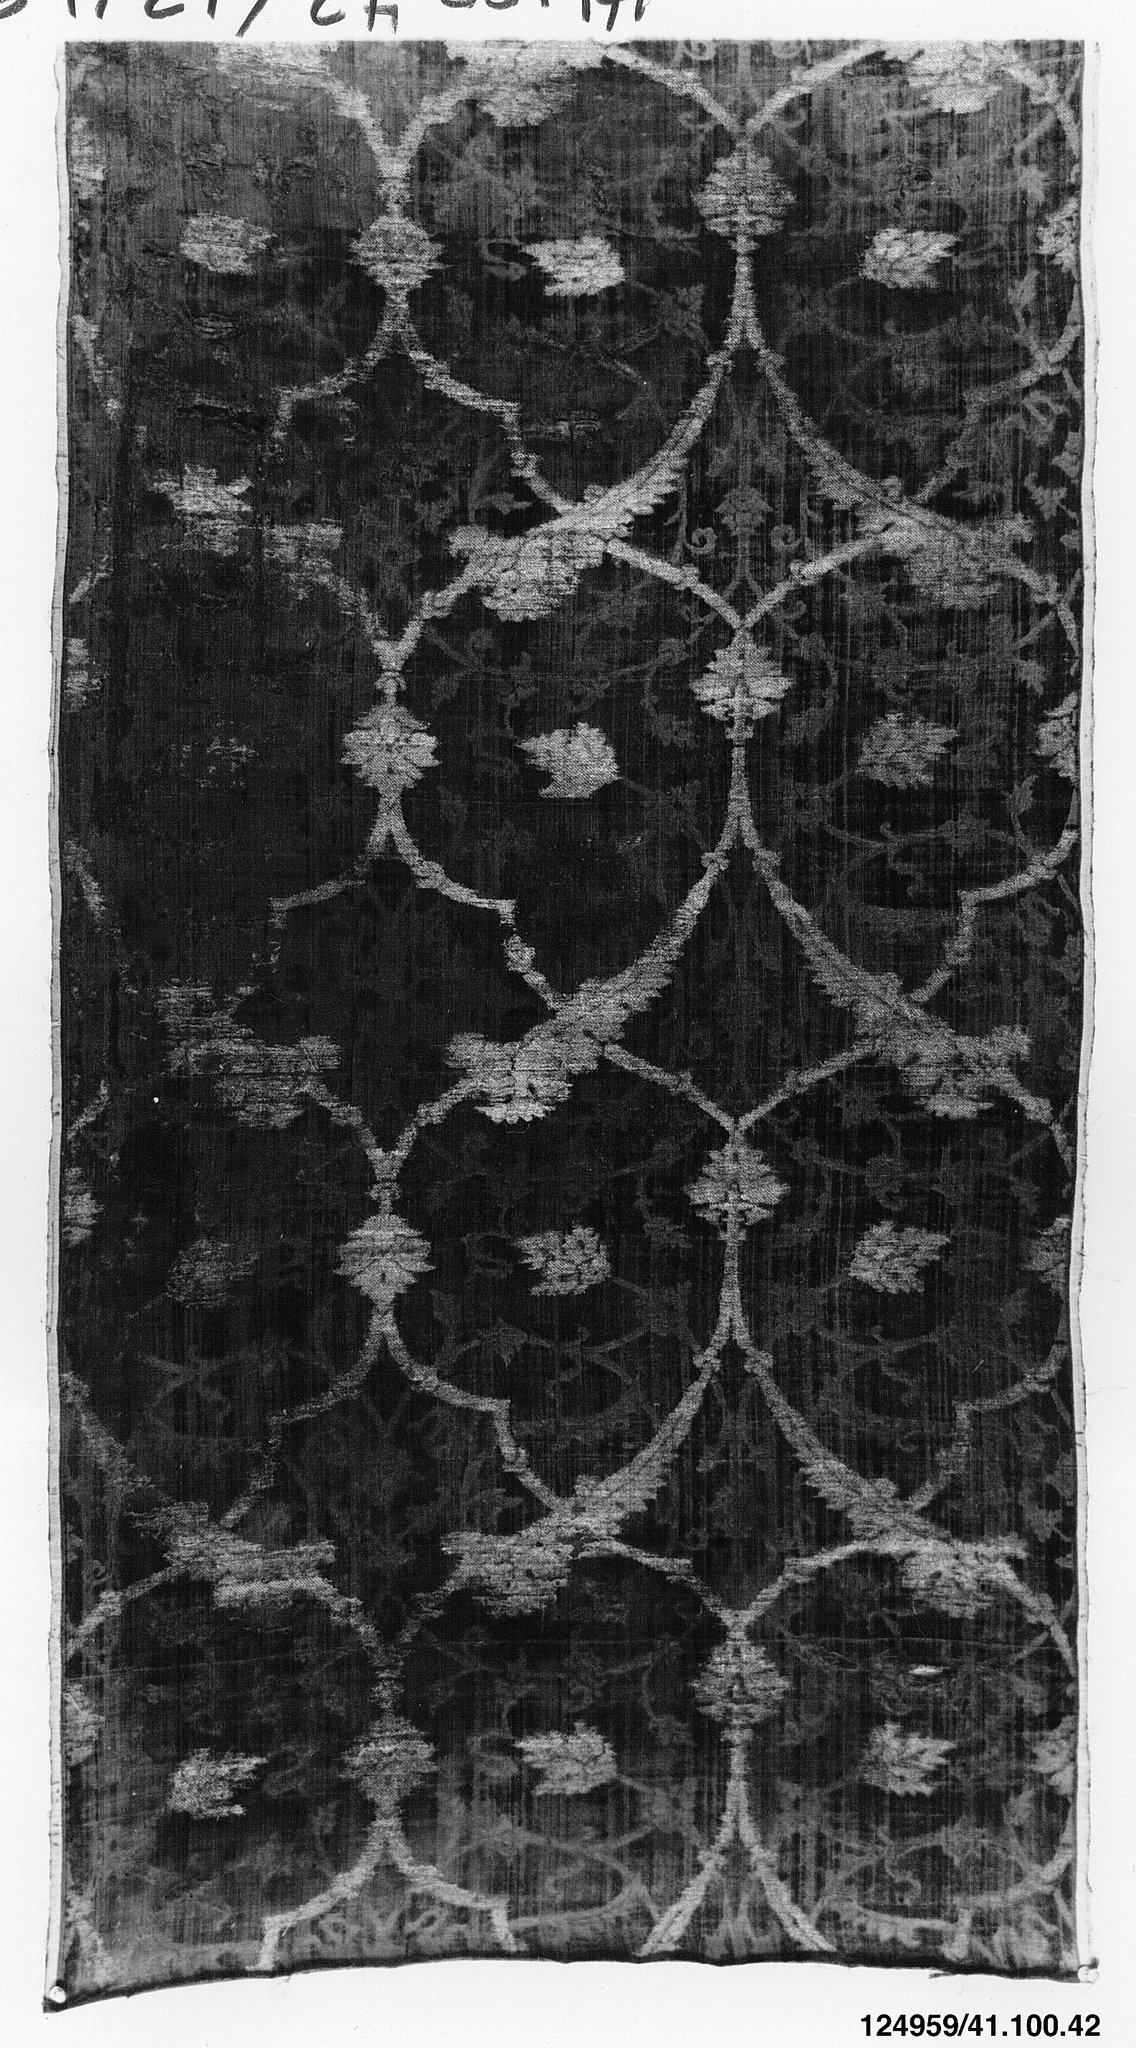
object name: fragment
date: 1500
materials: metal thread, silk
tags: leaves